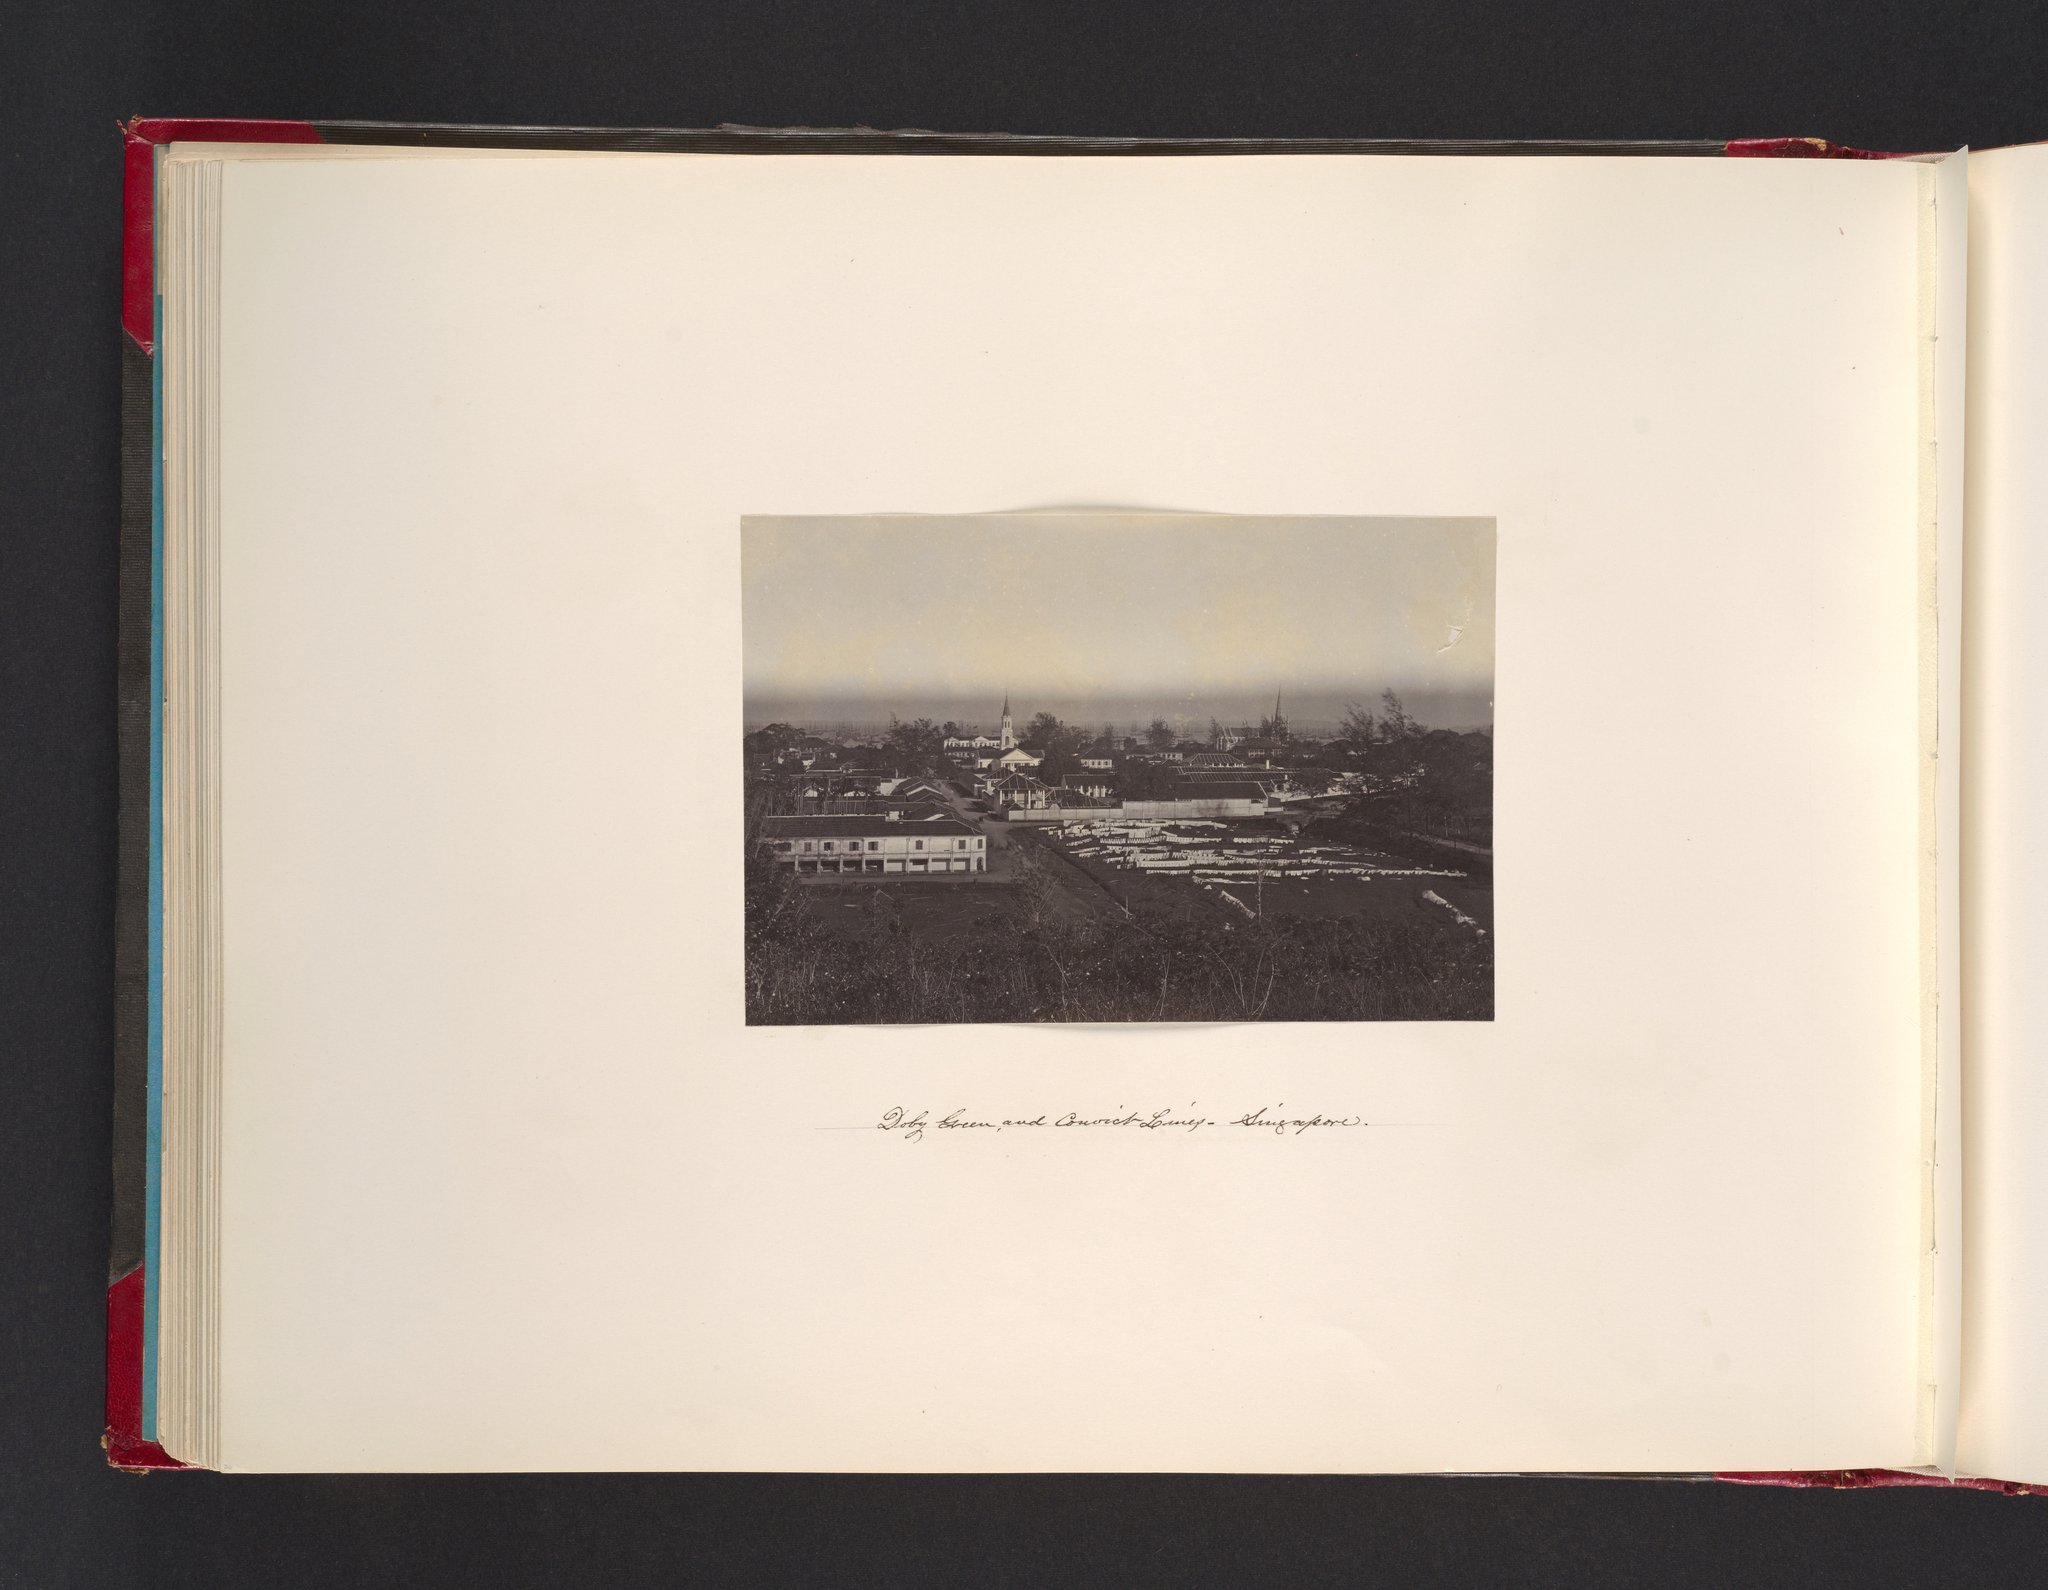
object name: photograph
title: [Houses in Singapore]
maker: john thomson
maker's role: artist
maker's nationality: british, scottish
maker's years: 1837-1921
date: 1865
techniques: albumen silver print, glass negative